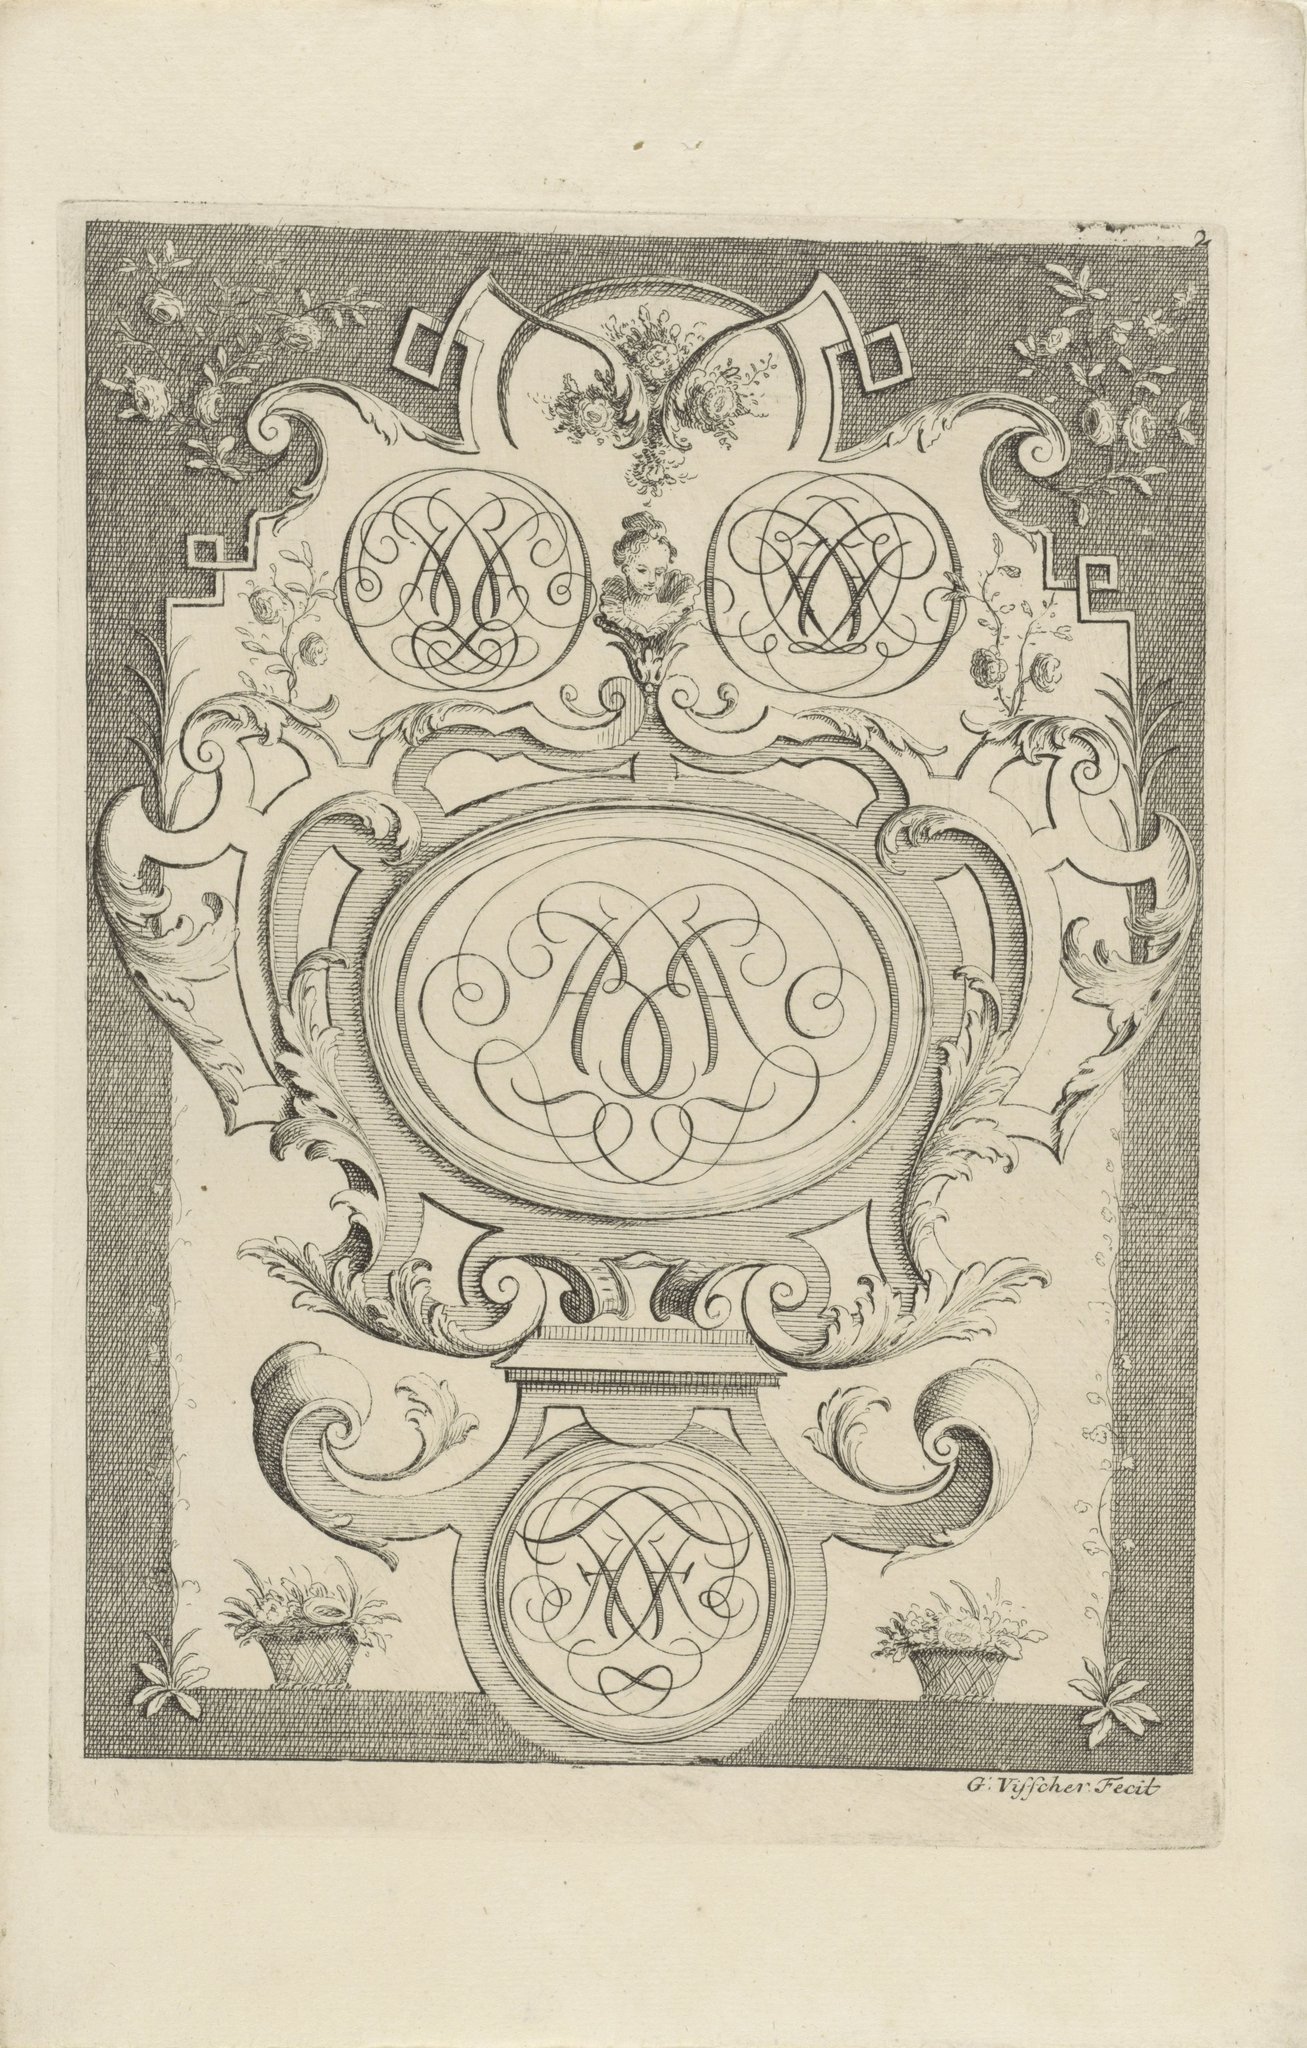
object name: ornament print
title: Het aghste Deel getrocke Naam Letteren gemaakt door Gerret Visscher Woont op Singel bij de Beuling Sluijs tot Amsterdam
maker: gerrit visscher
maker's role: print maker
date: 1690-1710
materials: paper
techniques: engraving, etching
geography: amsterdam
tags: foliage, tendrils, branches ~ ornament, flowers ~ ornament, letter combinations such as letterword, anagram, letter square, monogram, etc.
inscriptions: collector's mark: Lugt 2228